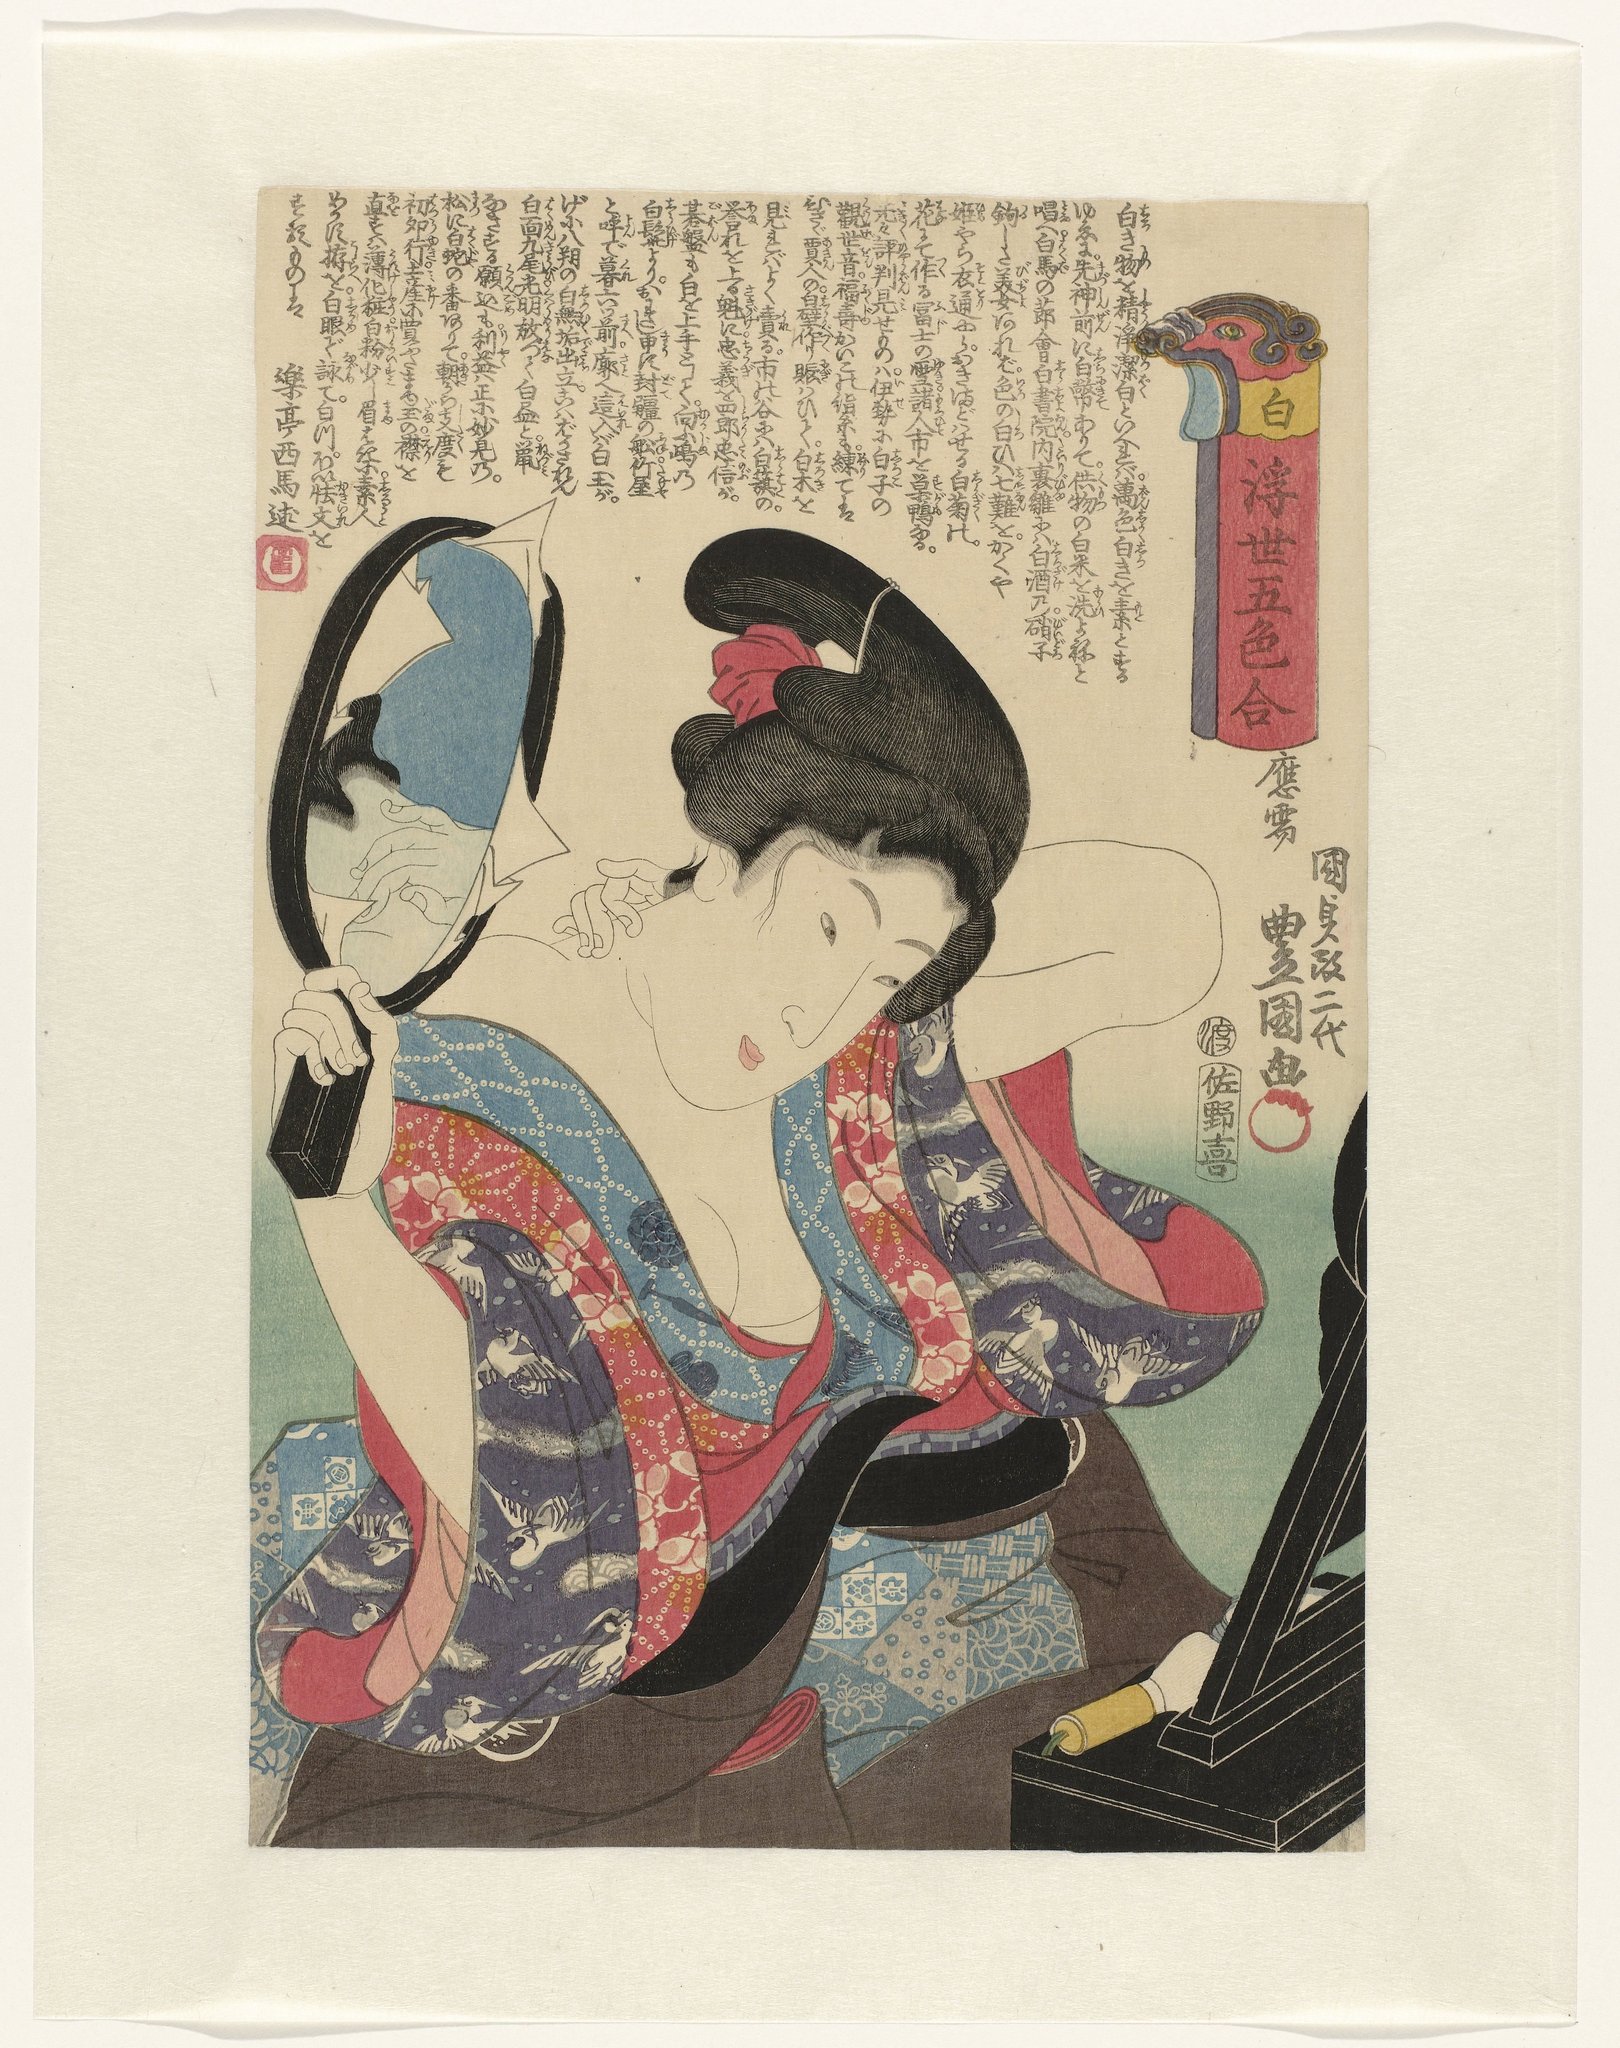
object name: print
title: Ukiyo goshiki awase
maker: utagawa kunisada (i)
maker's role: print maker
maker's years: 1786-1865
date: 1844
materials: paper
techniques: woodcut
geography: tokyo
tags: looking in the mirror; (possibly: contemplation of own beauty - aa - (for) women), making toilet, adult woman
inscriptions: date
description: Vrouw, met handspiegel in rechter hand, haar nek bekijkend in staande spiegel waaronder witte make-up en kwast liggen.